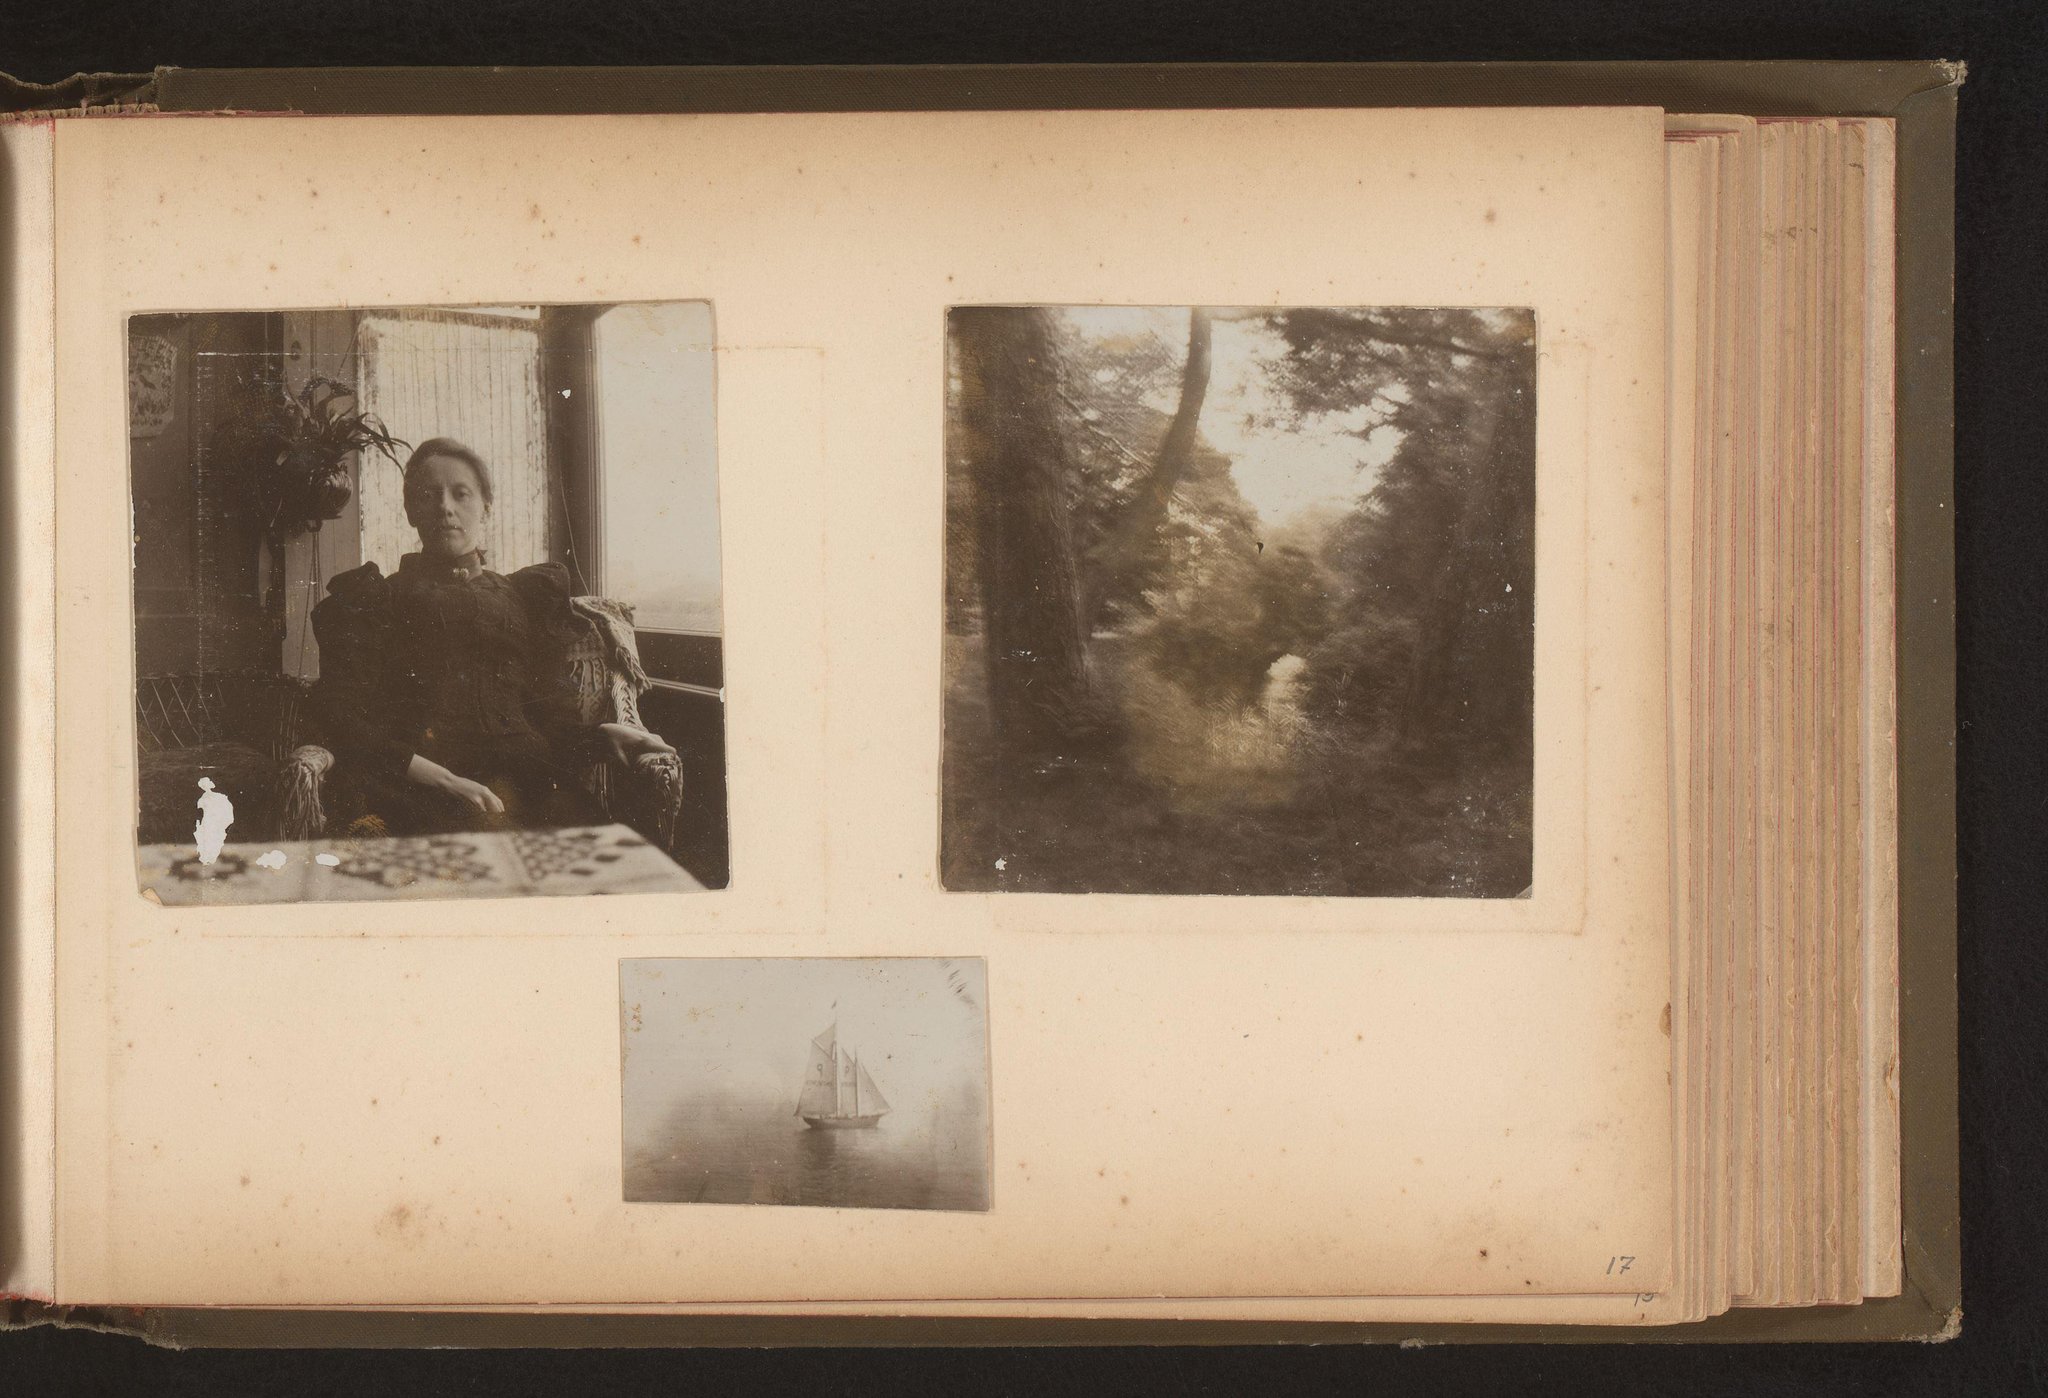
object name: photograph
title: Drie foto's, portret van een vrouw, een bosgezicht en een zeilschip op zee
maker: Anonymous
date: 1895-1910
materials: paper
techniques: collodion silver print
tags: adult woman, sailing-ship, sailing-boat, forest, wood, anonymous historical person portrayed - bb - woman, netherlands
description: Deze foto's maken deel uit van een album.